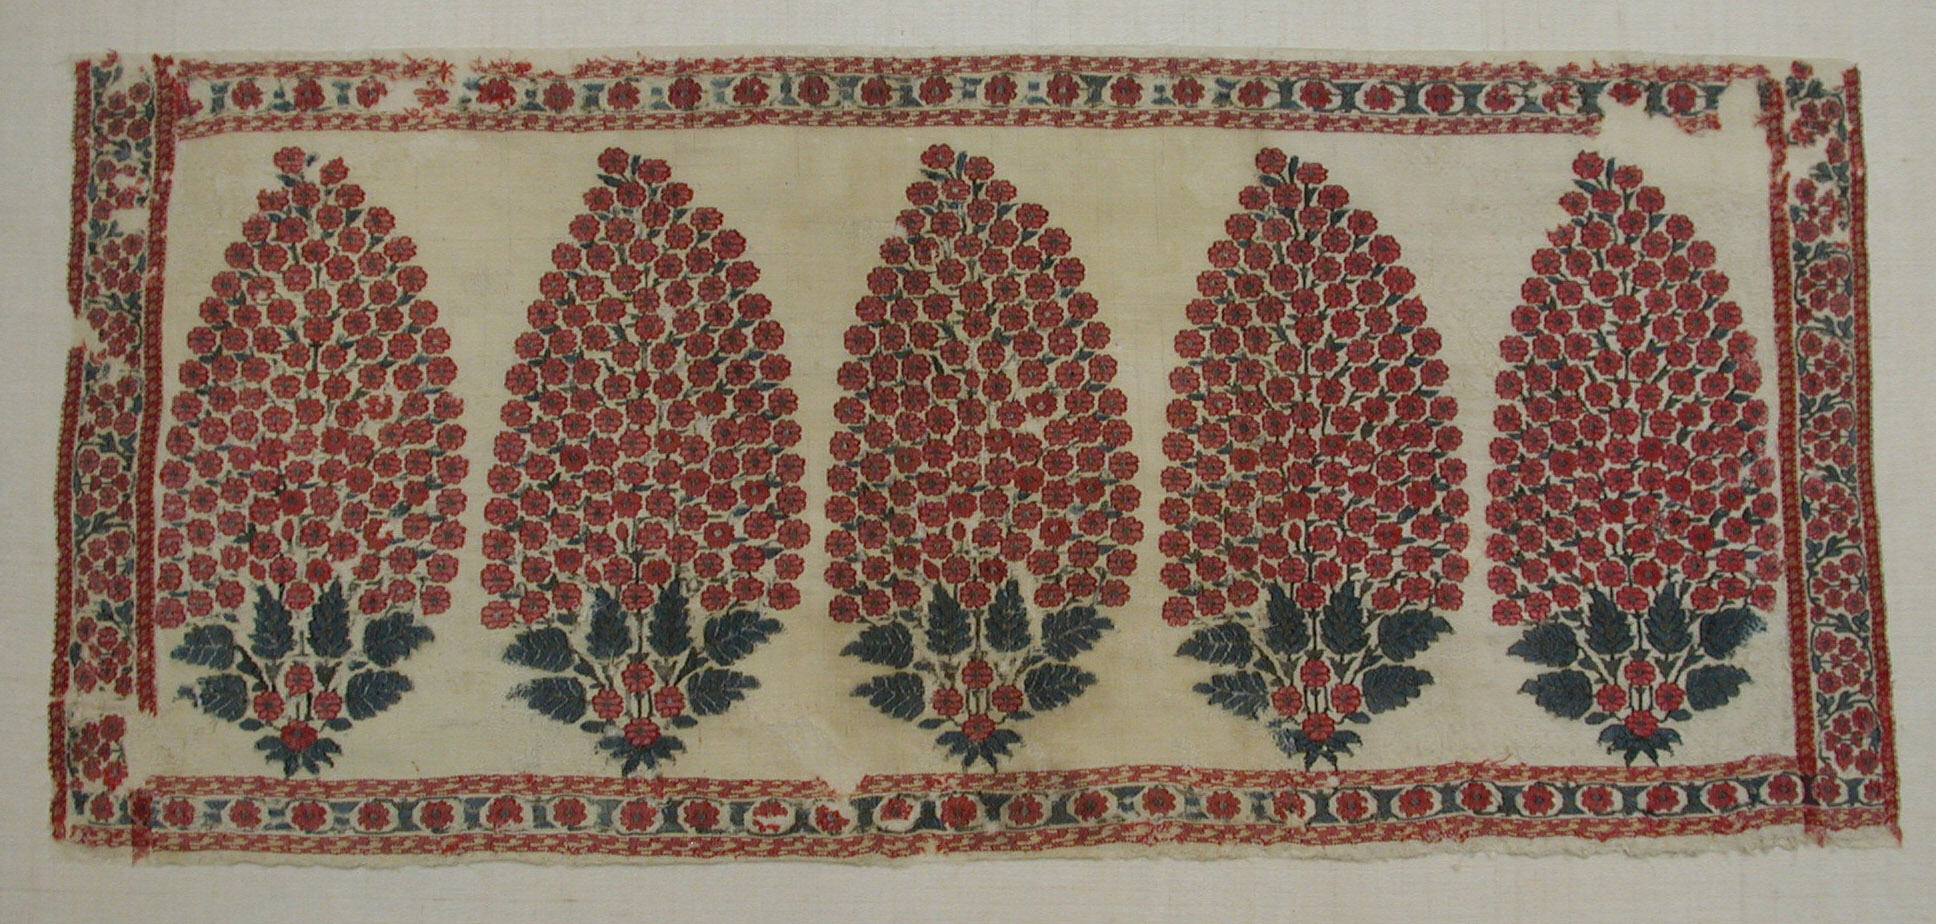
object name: textile fragment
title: End Panel of a Sash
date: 1667-1733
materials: wool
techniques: interlocking, weave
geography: india